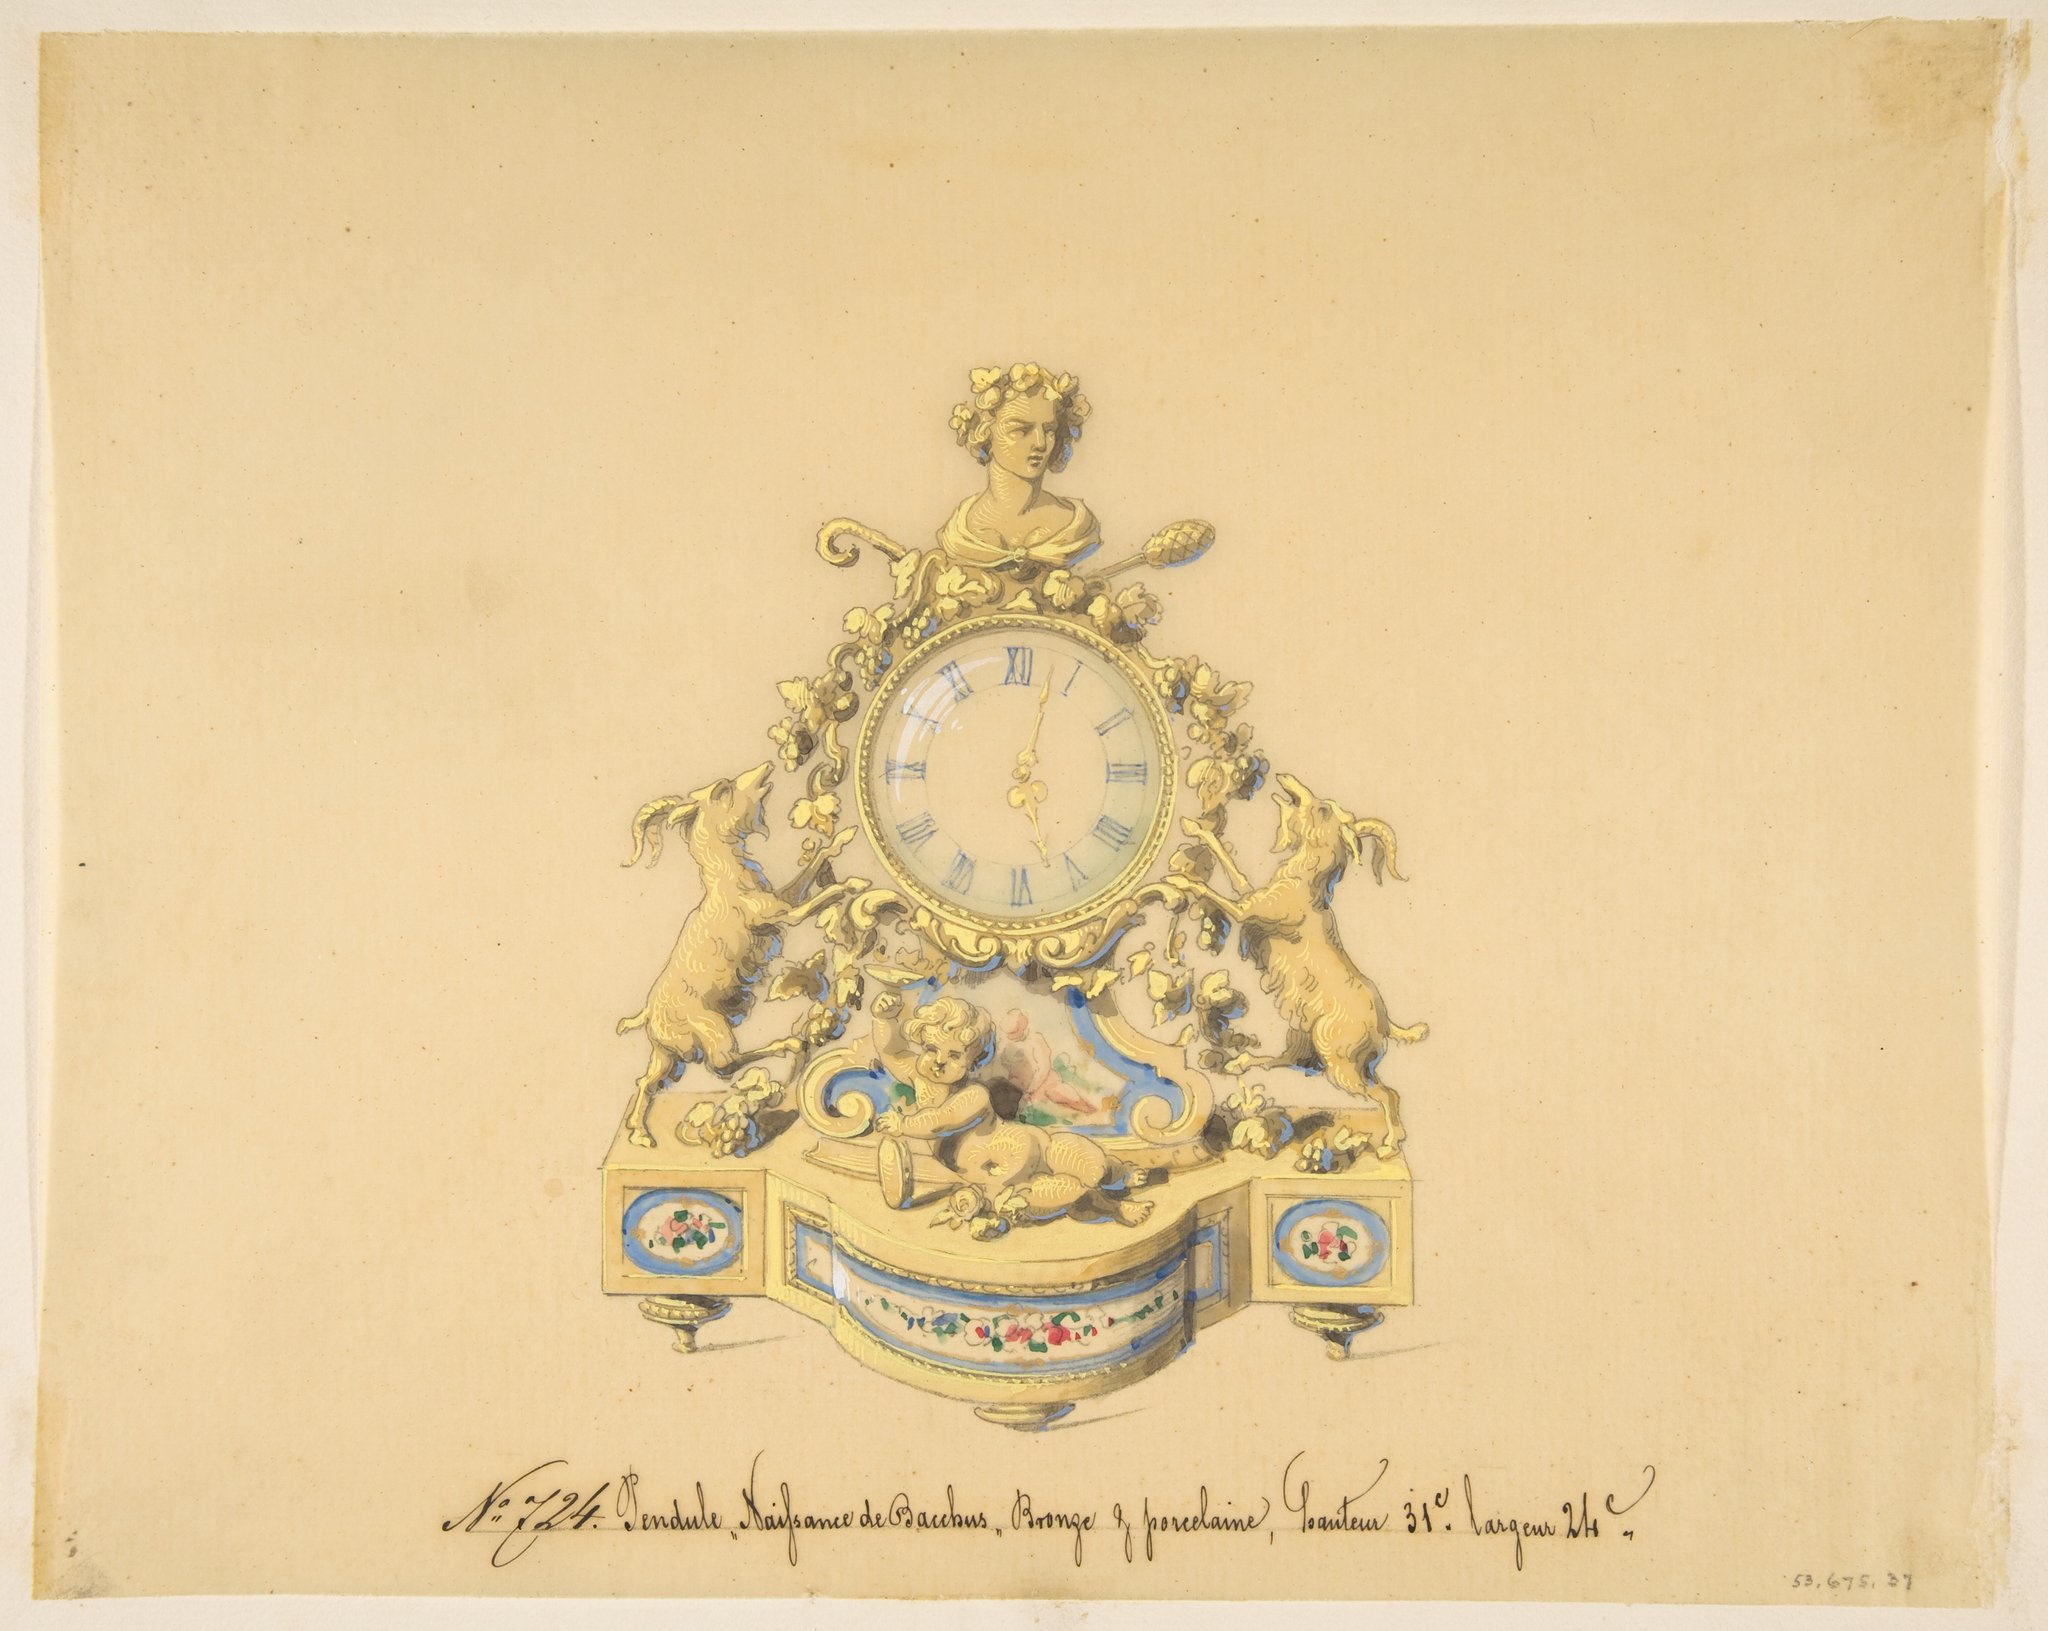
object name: drawing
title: Design for a Clock: Birth of Bacchus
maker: anonymous, french, 19th century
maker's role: artist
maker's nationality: french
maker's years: 1800-1900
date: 1801-1900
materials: gouache, graphite, watercolor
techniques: brush, wash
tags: clocks